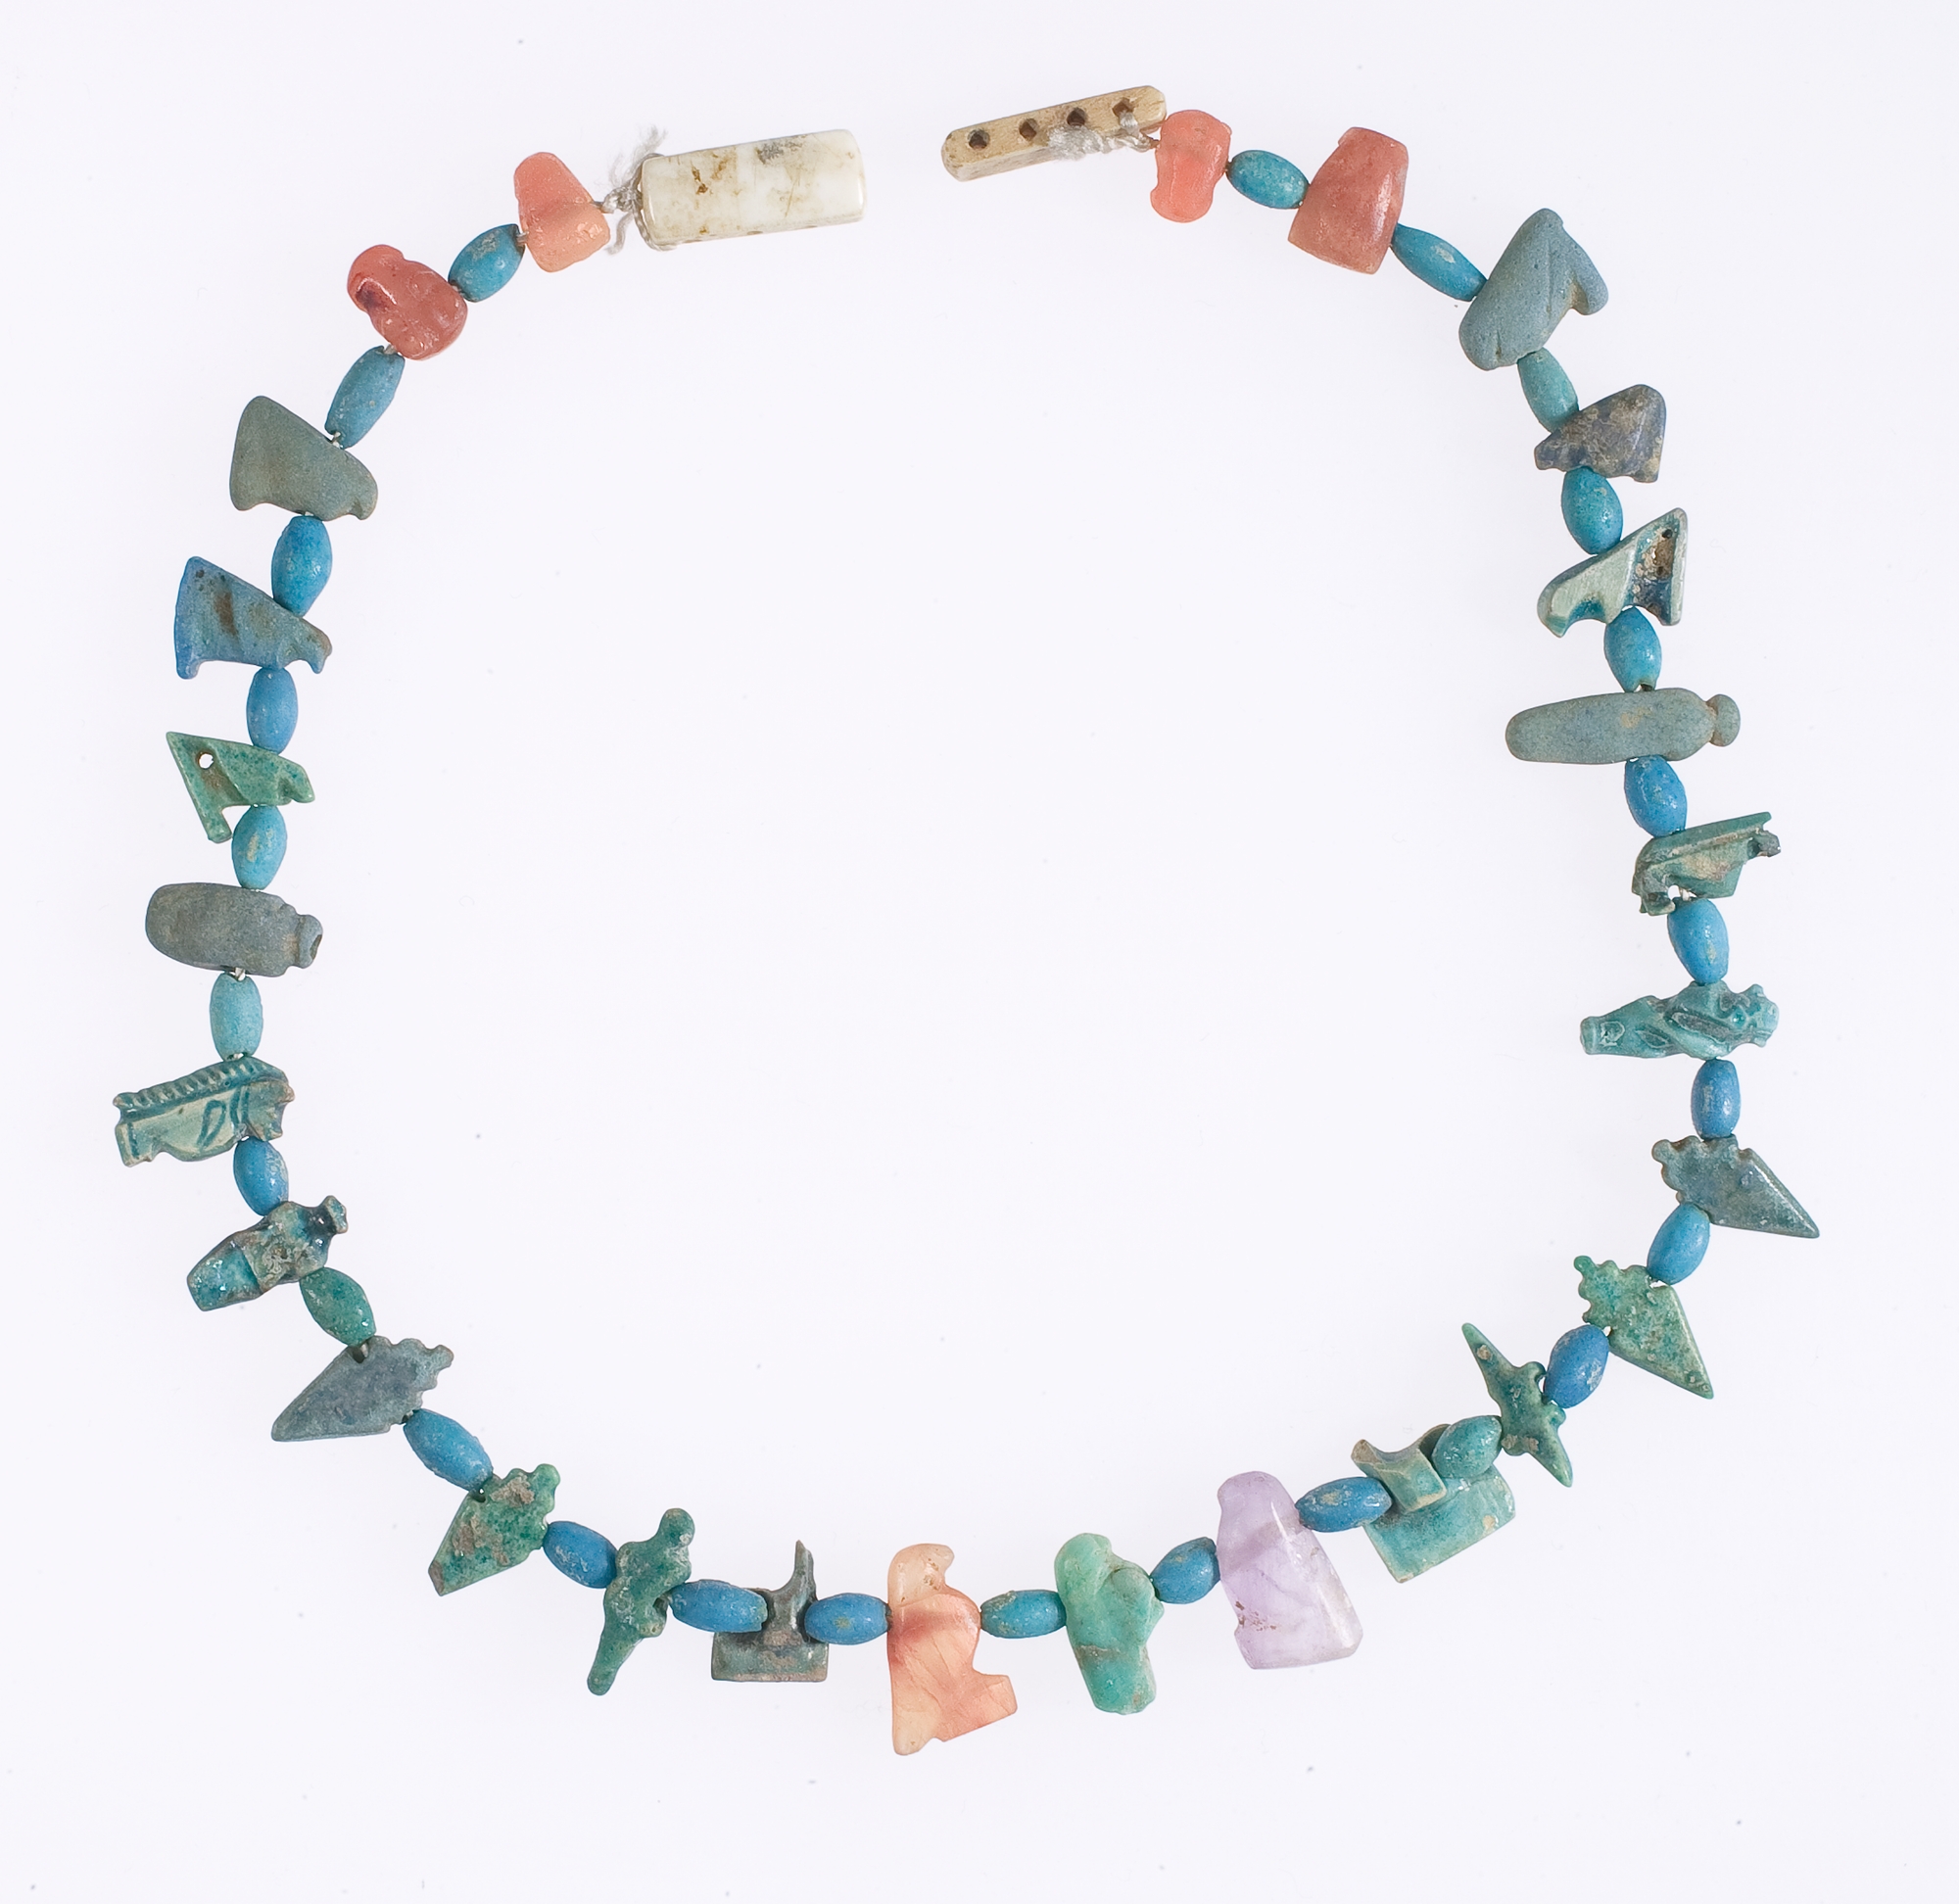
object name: necklace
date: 1991-1450 BCE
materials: faience, glass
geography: egypt